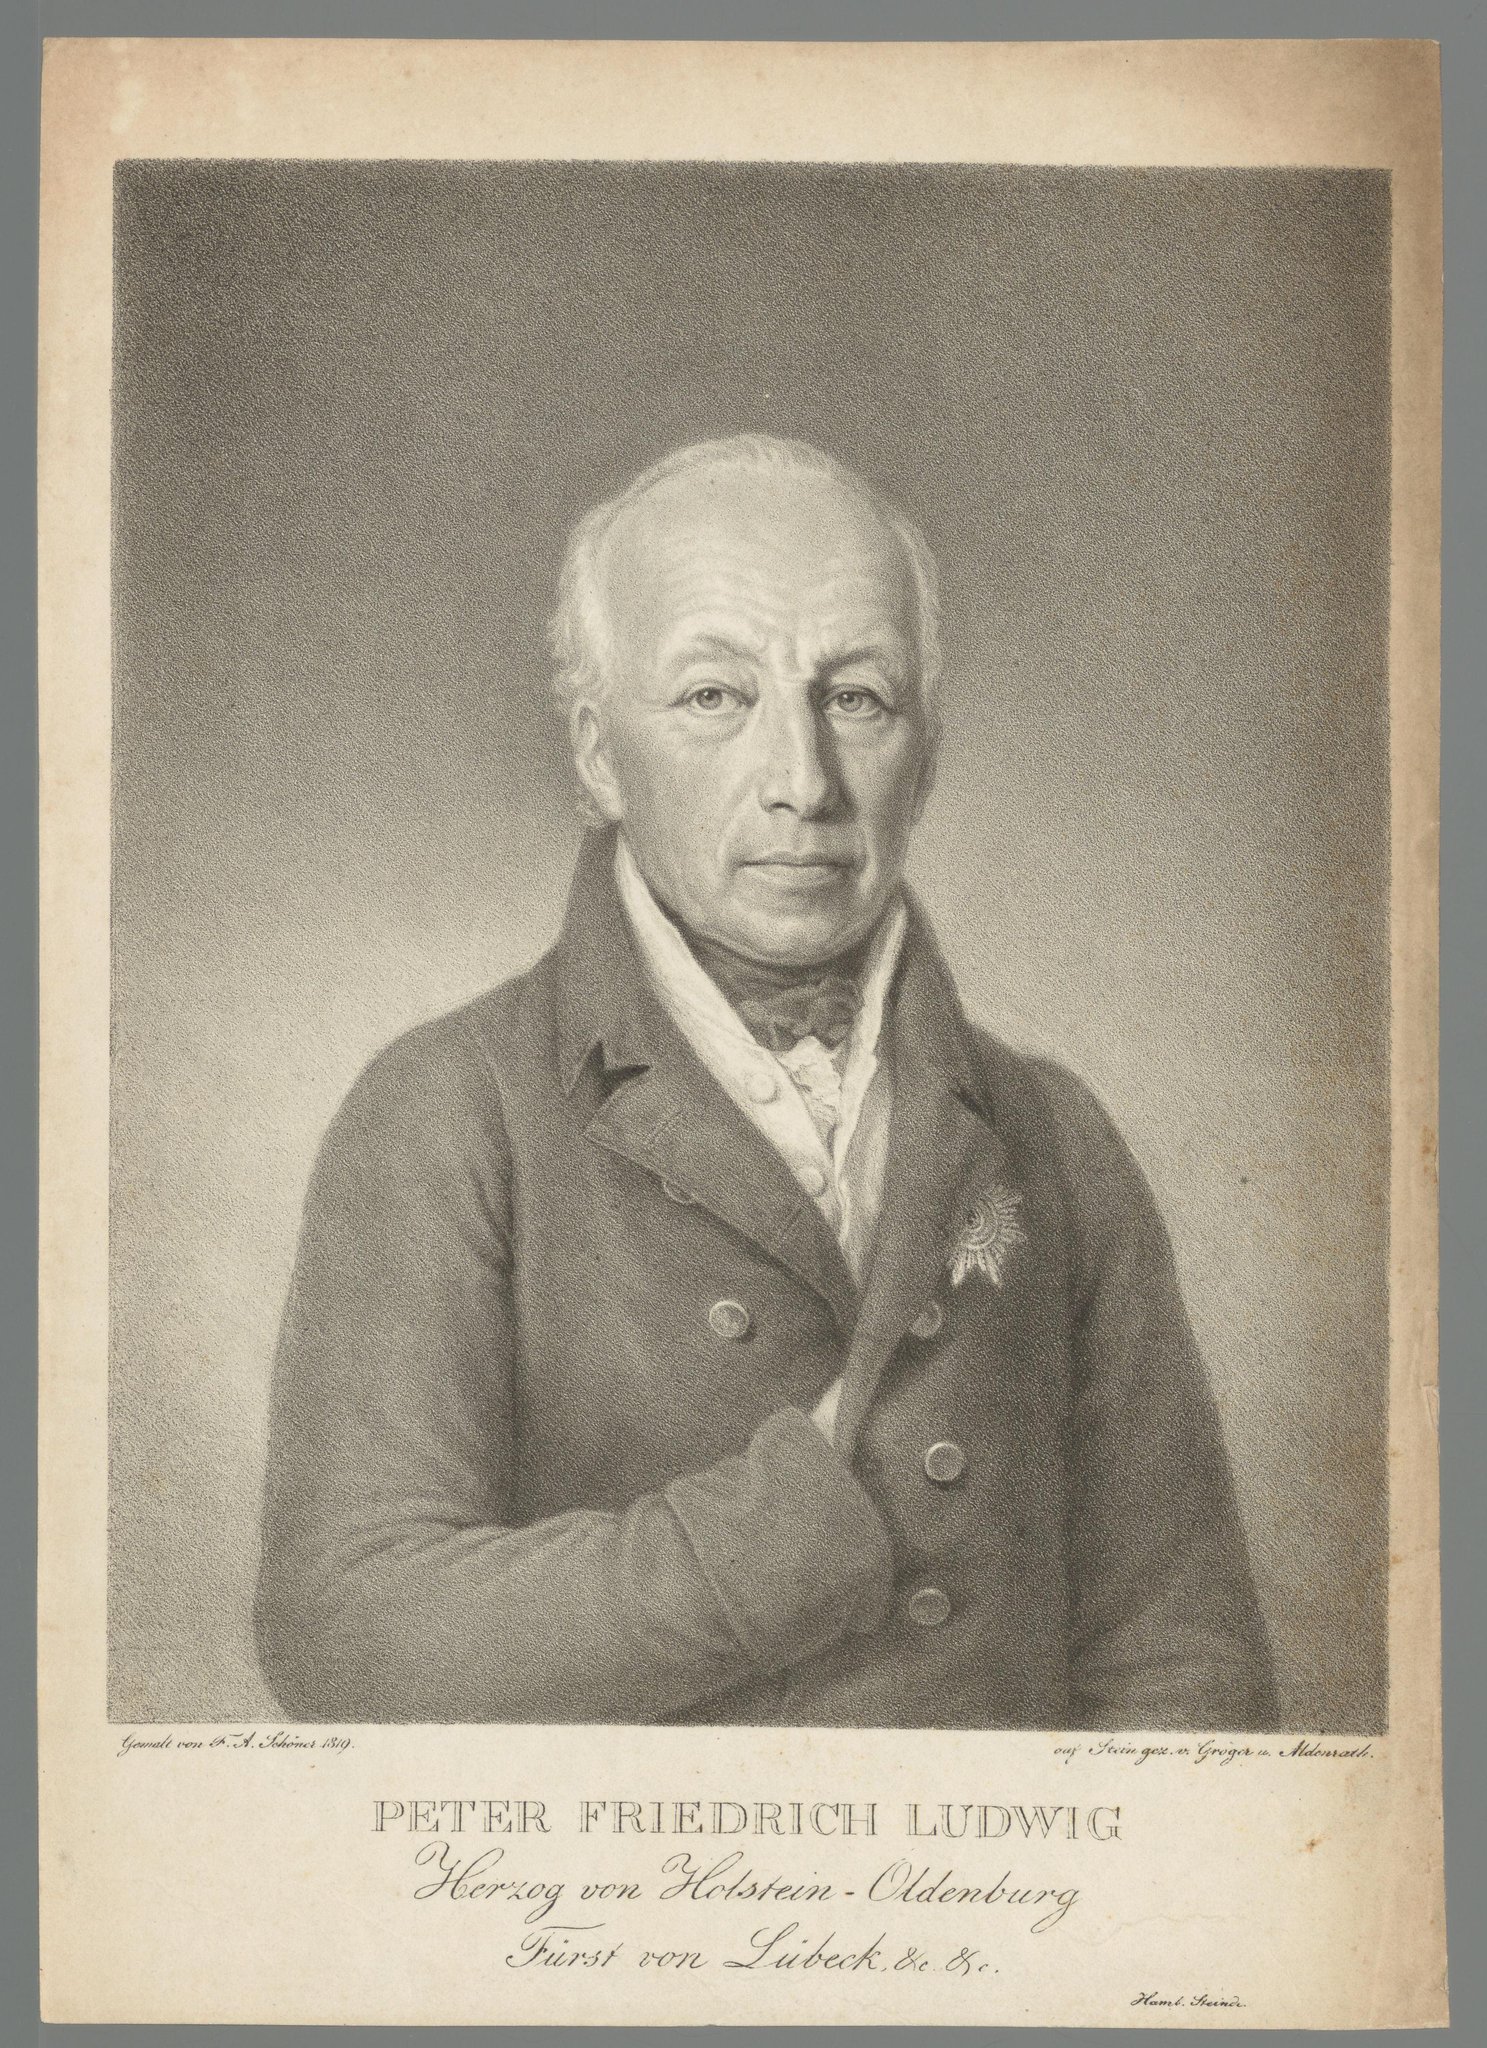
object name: print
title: Peter Friedrich Ludwig, Herzog von Holstein-Oldenburg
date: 1819-1838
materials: paper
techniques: lithograph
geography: hamburg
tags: adult man, historical persons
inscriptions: collector's mark: Lugt 2228